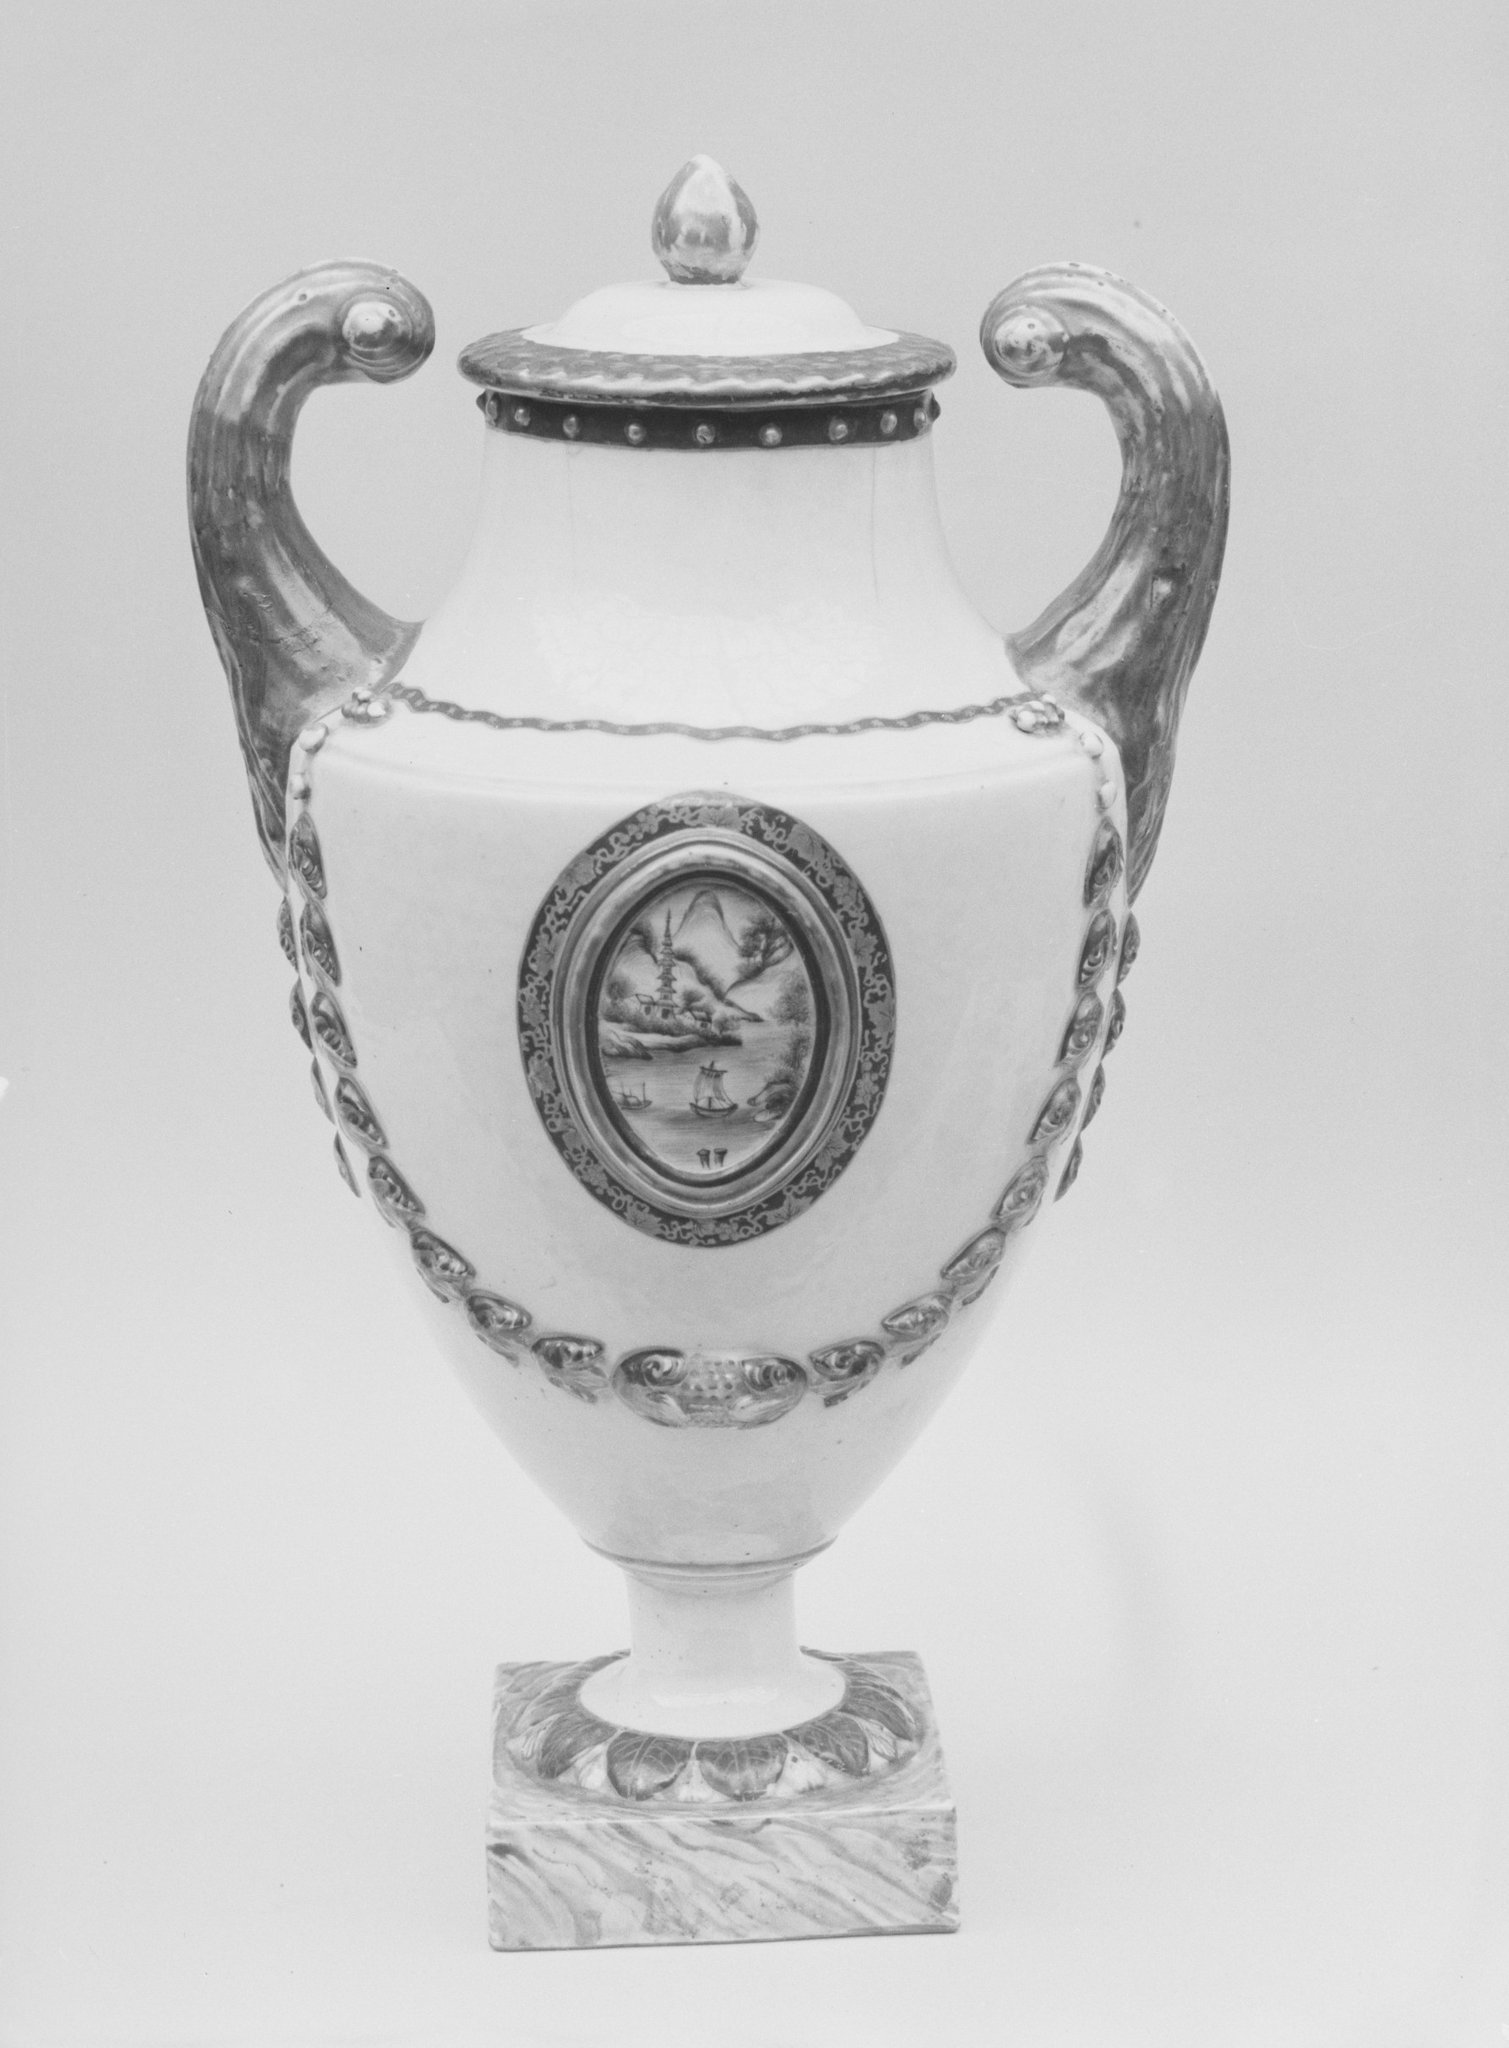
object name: vase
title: Covered Vase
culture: chinese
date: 1785-1815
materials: porcelain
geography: china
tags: landscapes